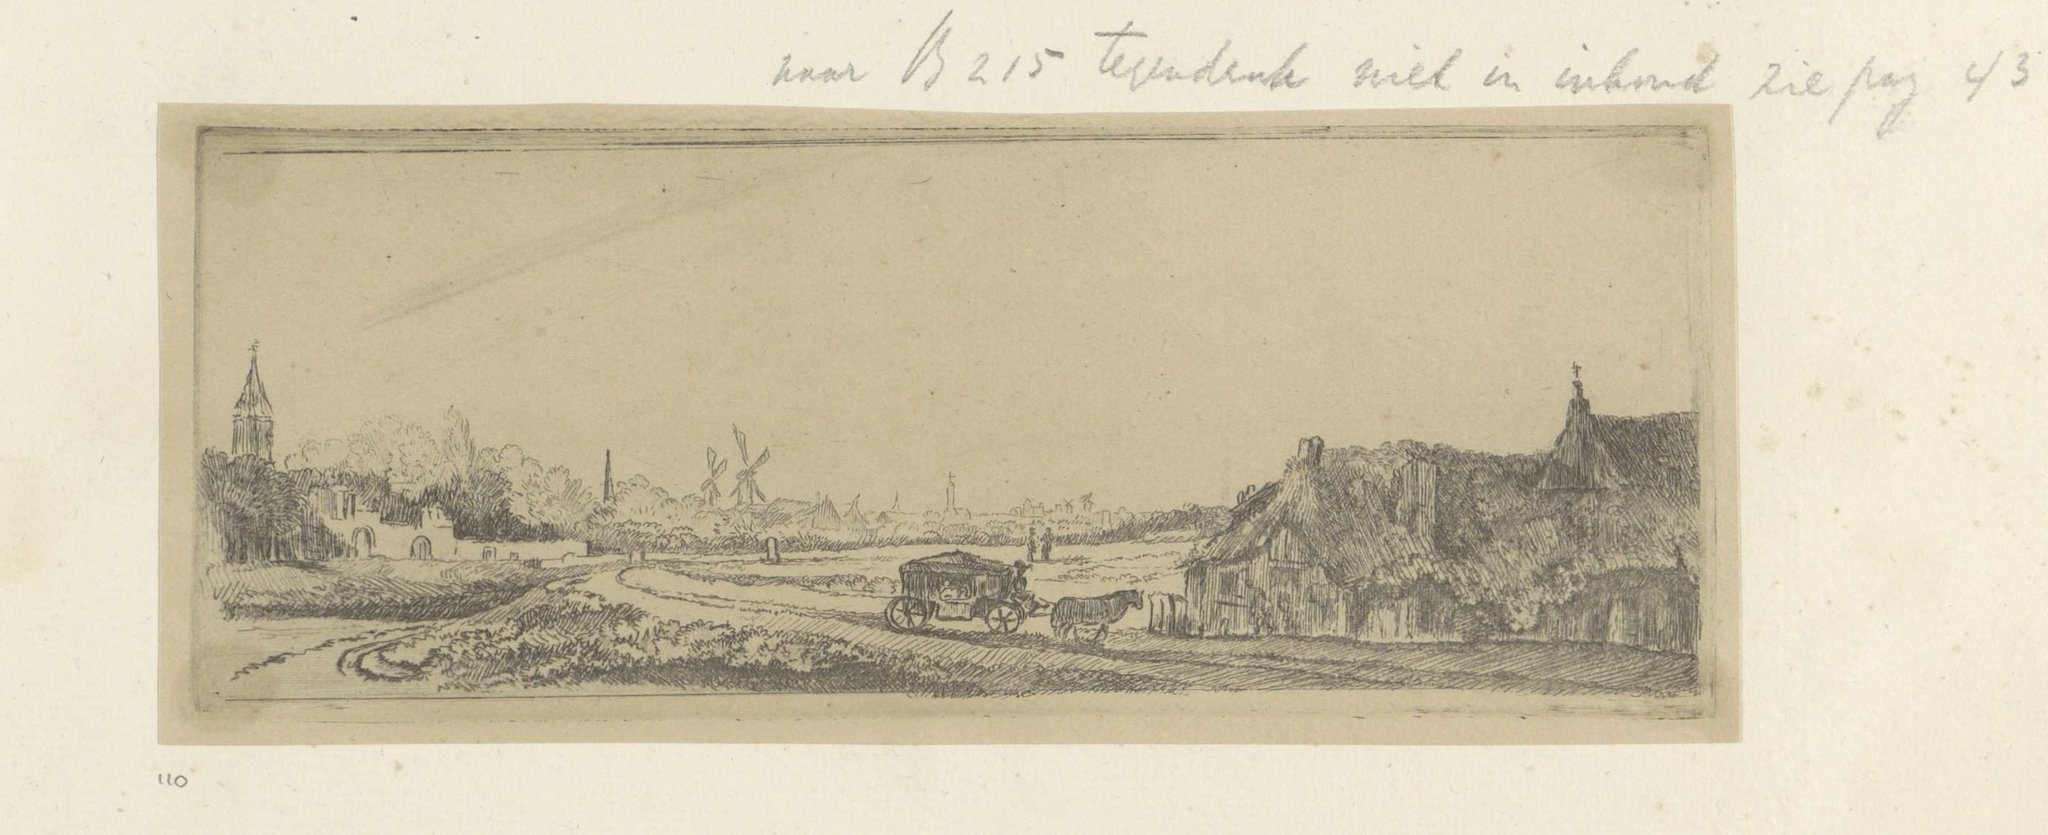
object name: print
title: Recueil de quatre-vingt-cinq estampes originales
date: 1728-1786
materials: paper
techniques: etching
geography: paris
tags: landscapes